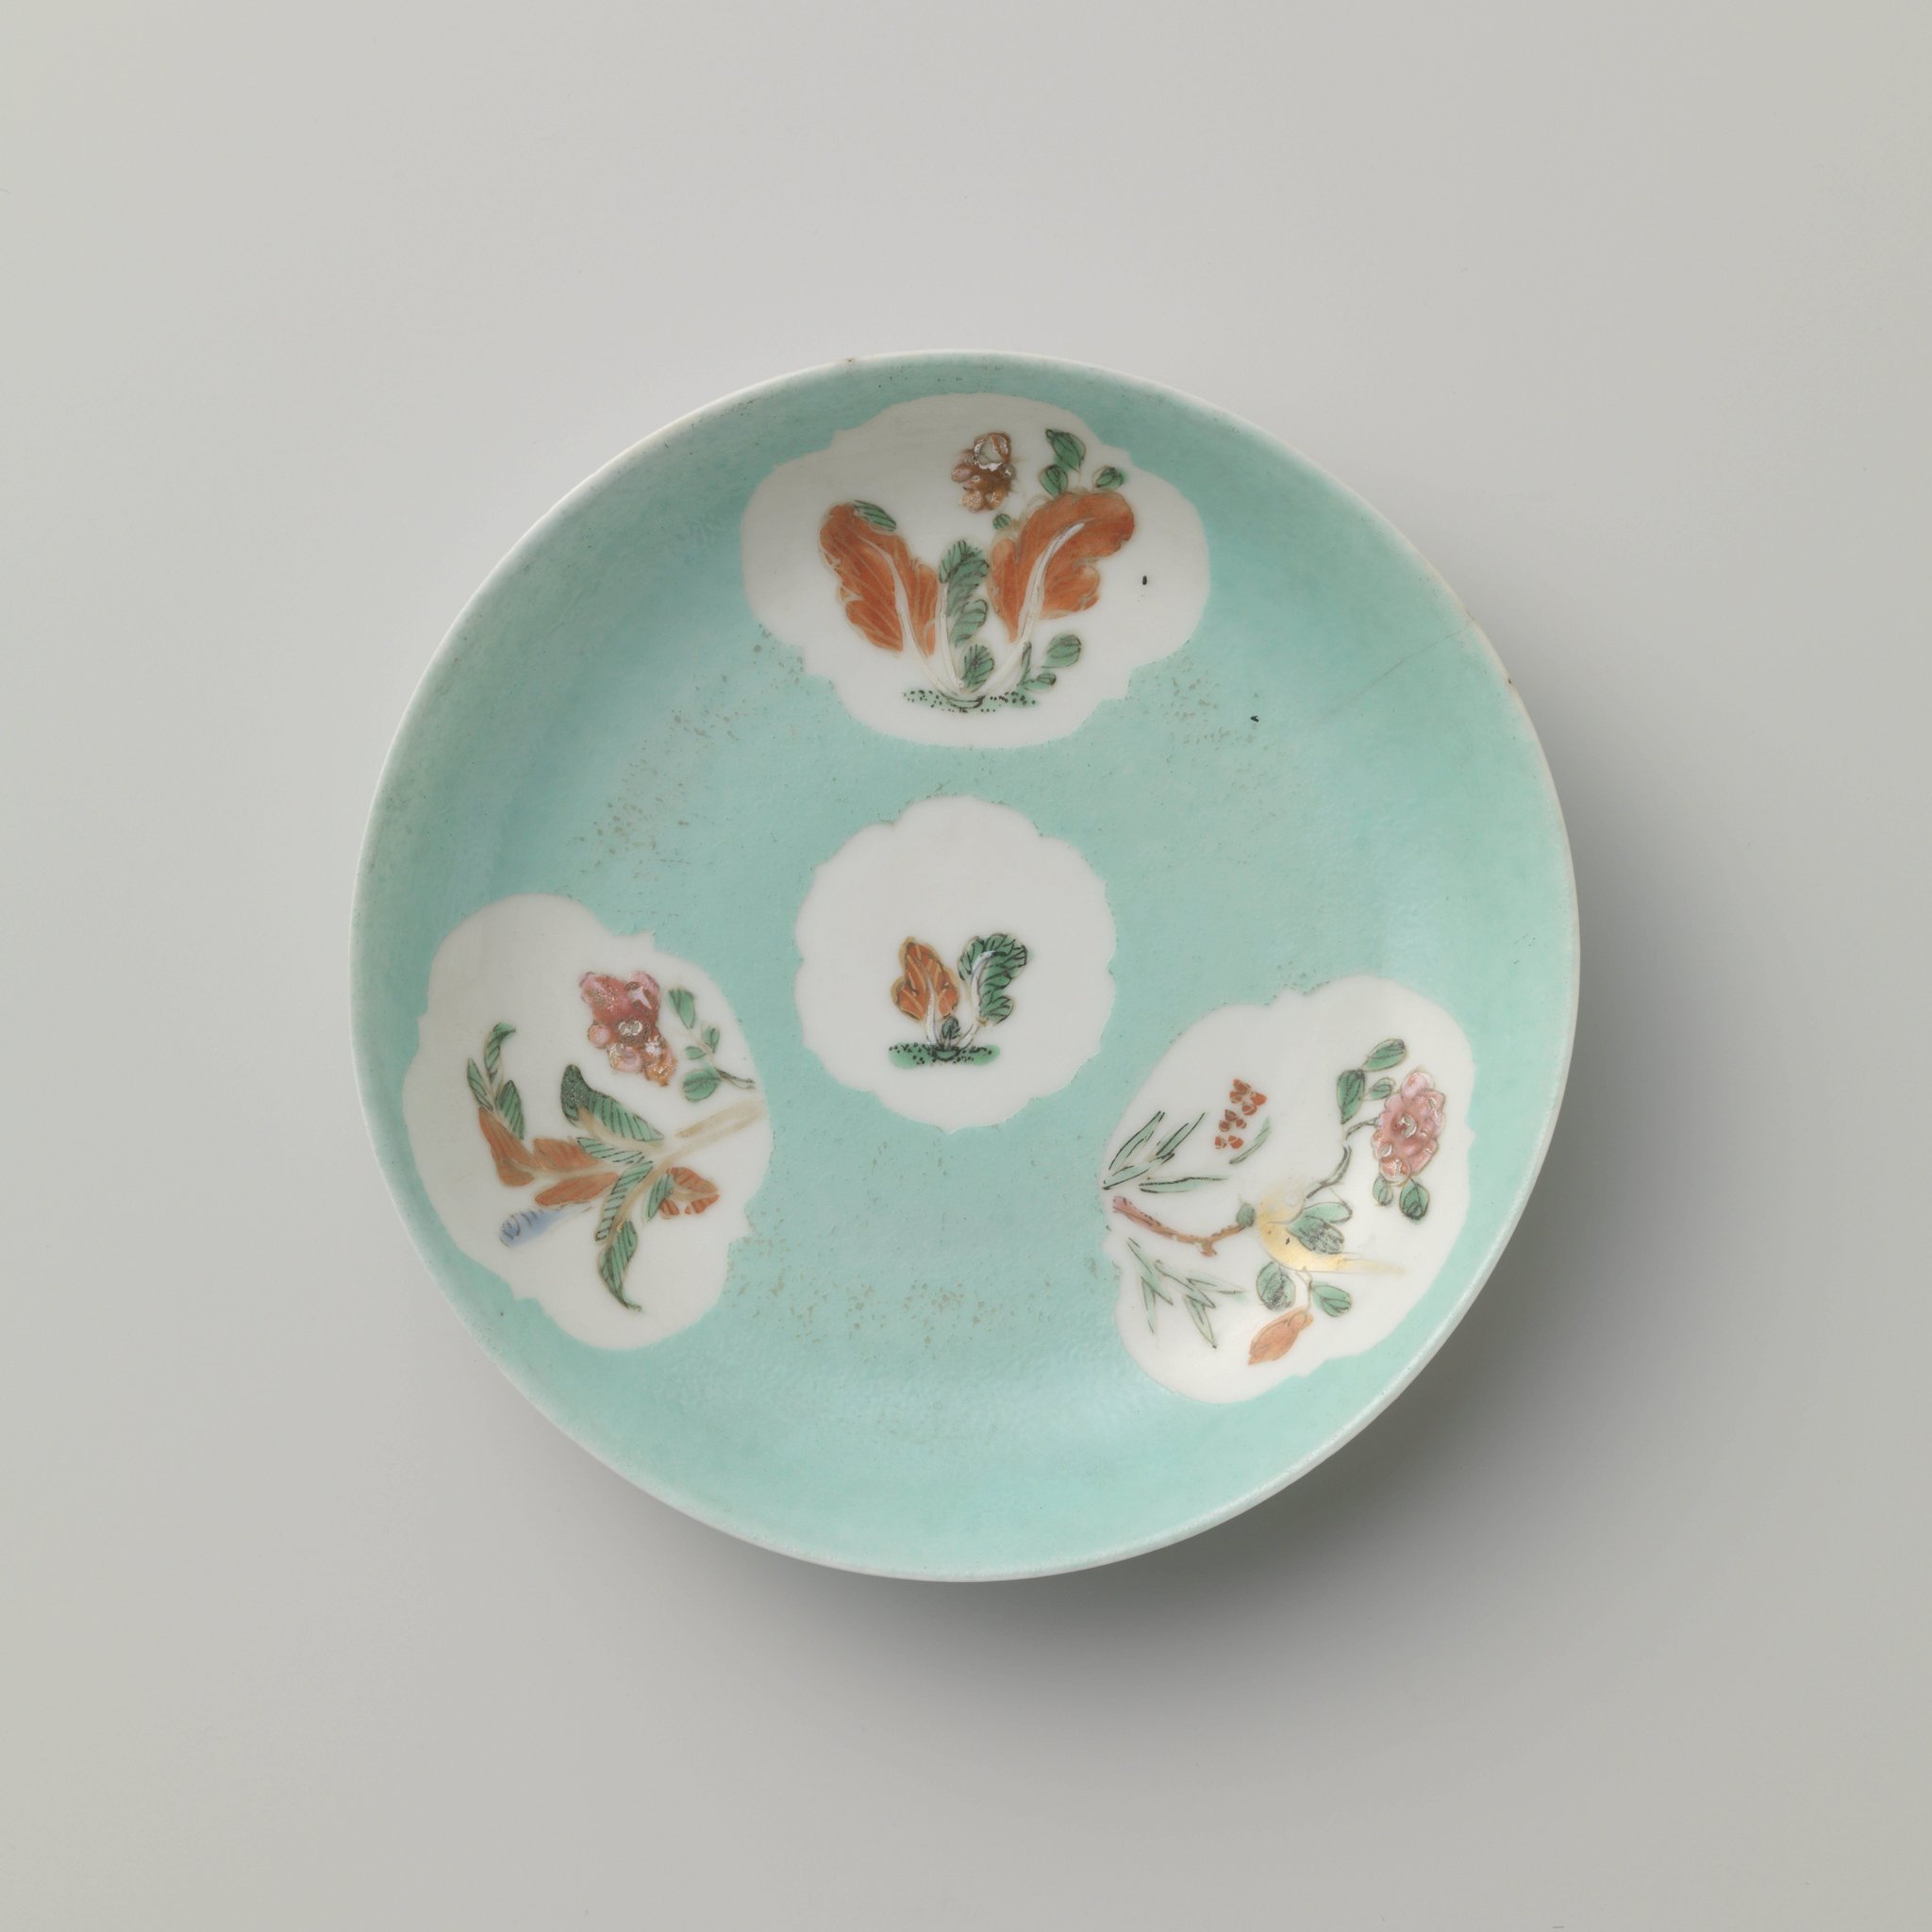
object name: platter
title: Saucer with flowering plants in shaped panels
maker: Anonymous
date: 1760-1780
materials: glaze, gold, paint, porcelain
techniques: firing, gilding, turning, vitrification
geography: china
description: Schotel van porselein, bedekt met een turquoise glazuur en berschilderd in blauw, rood, roze, groen, zwart en goud. De schotel is aan de voorzijde bedekt met een turquoise glazuur met hierin uitgespaard in het centrum een geschulpt medaillon met plant, daaromheen drie uitgespaarde cartouches met bloeiende planten en een vogel op een tak. Een barst in de rand. Famille rose.